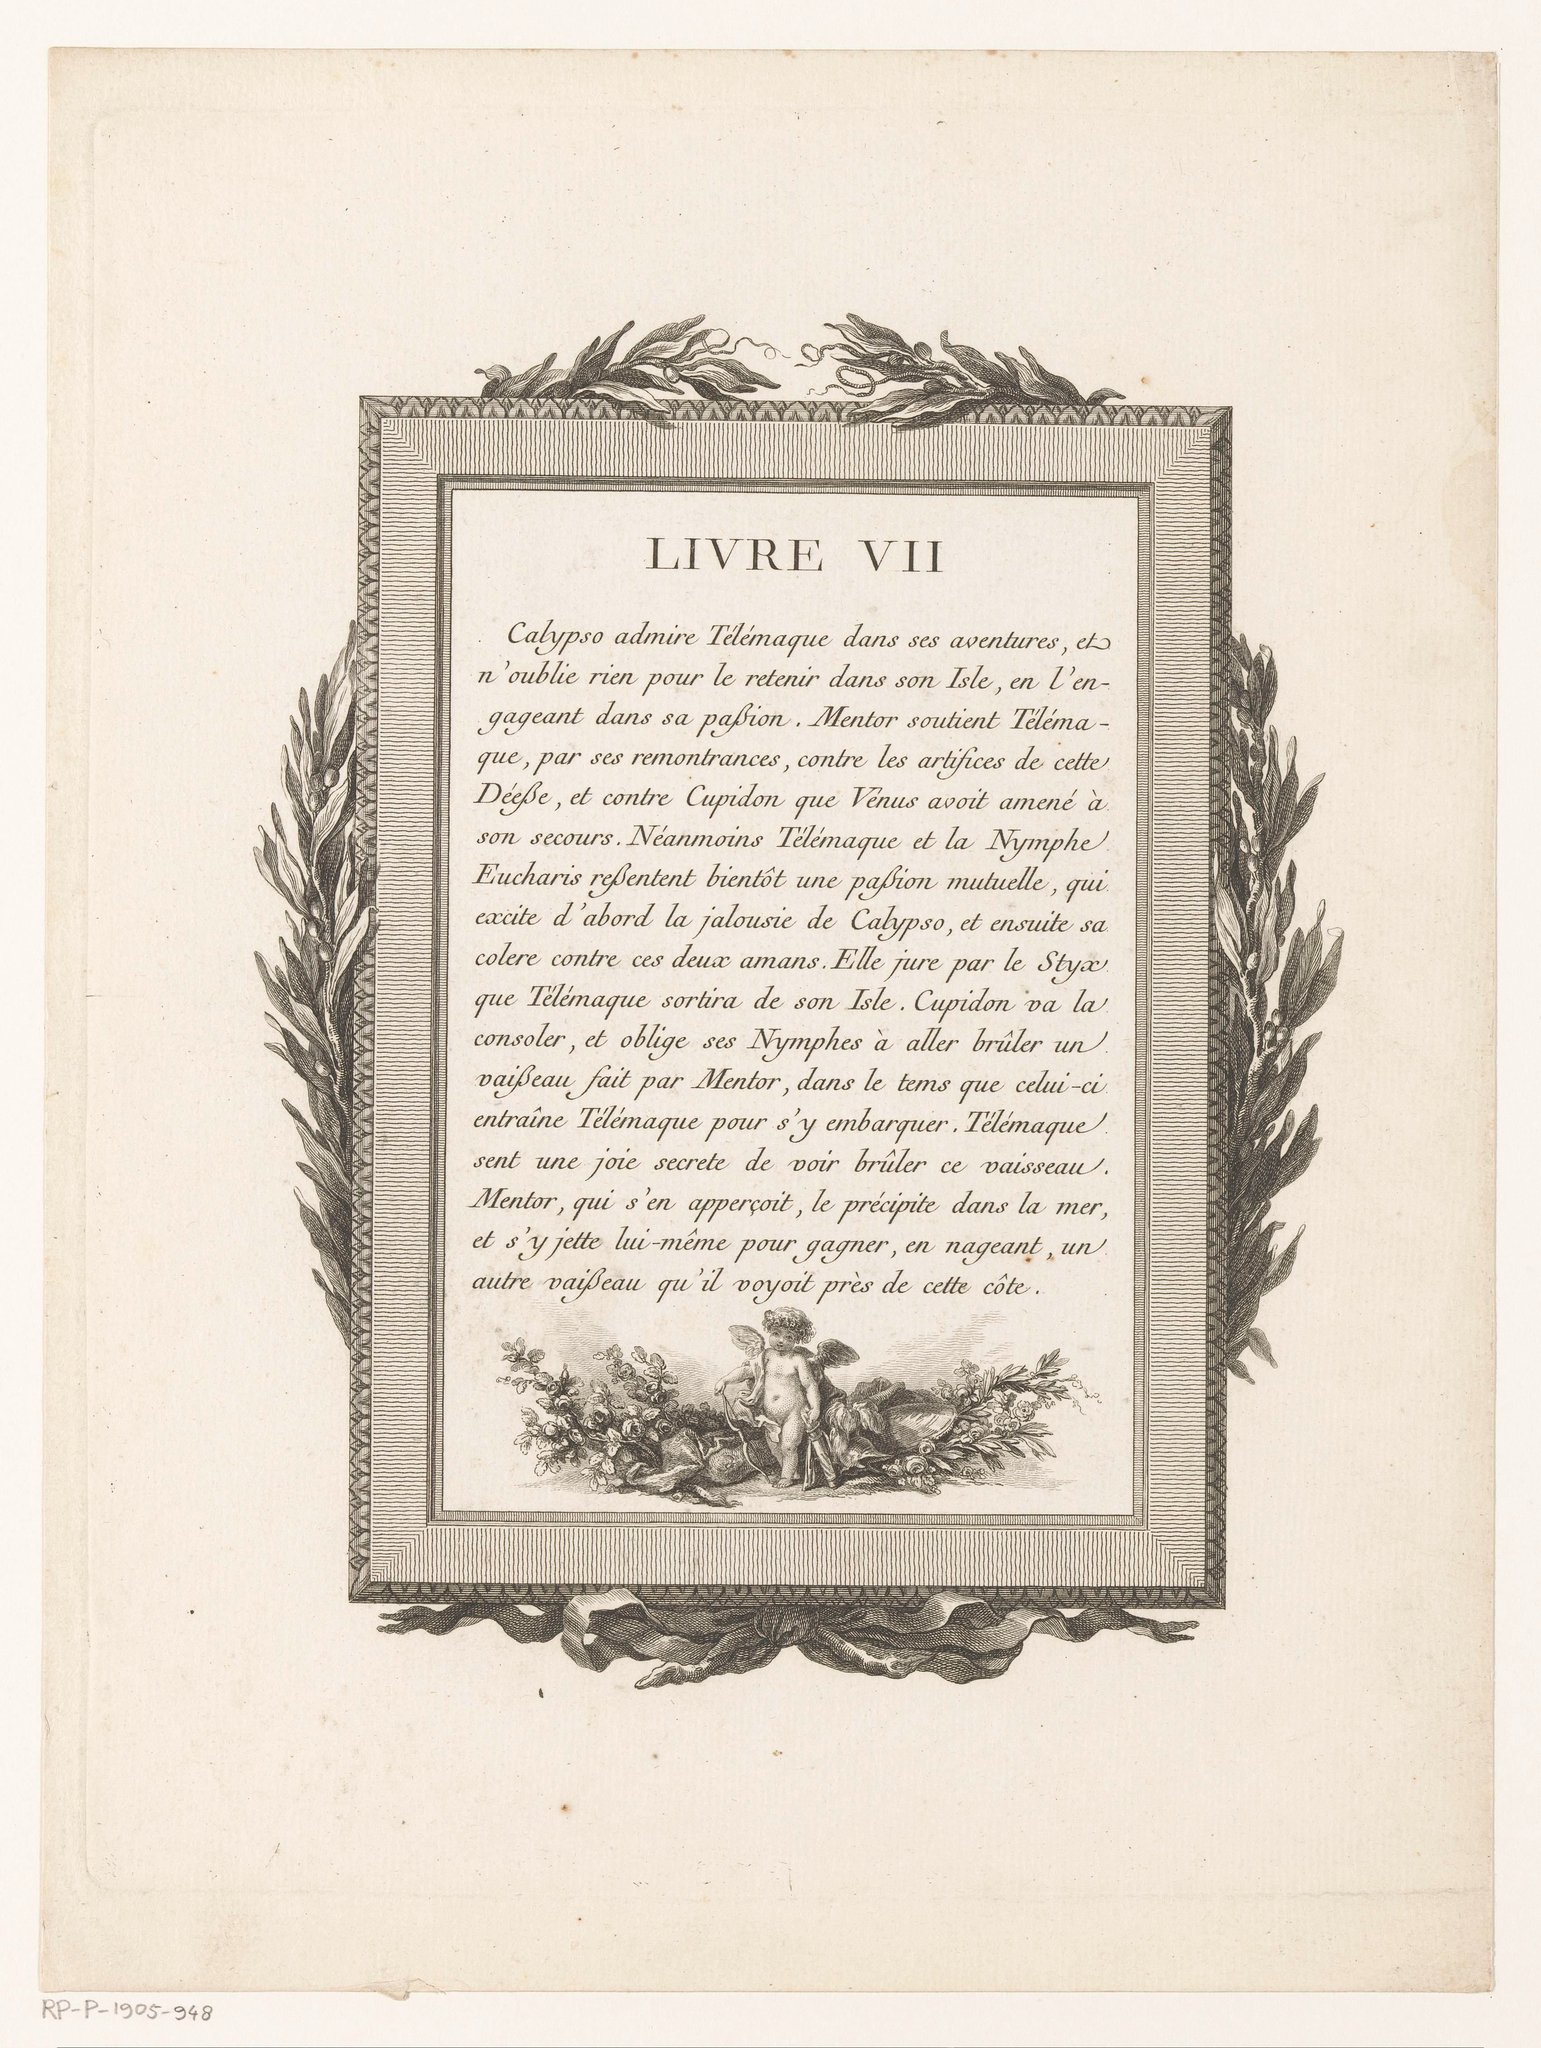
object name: book illustration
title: Omkaderde Franse tekst met een putto en olijftakken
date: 1785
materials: paper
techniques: engraving, etching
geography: paris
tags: (fenelon, telemachus) specific works of literature (with author, title), ornament ~ festoon, garland, cupids: 'amores', 'amoretti', 'putti'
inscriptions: collector's mark: Lugt 2228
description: Zeventienregelige Franse tekst, getiteld 'Livre VII' met daaronder een afbeelding van een putto staand tussen rozentakken. Het geheel wordt gekaderd door een sierlijst met olijftakken en onderaan een strik.